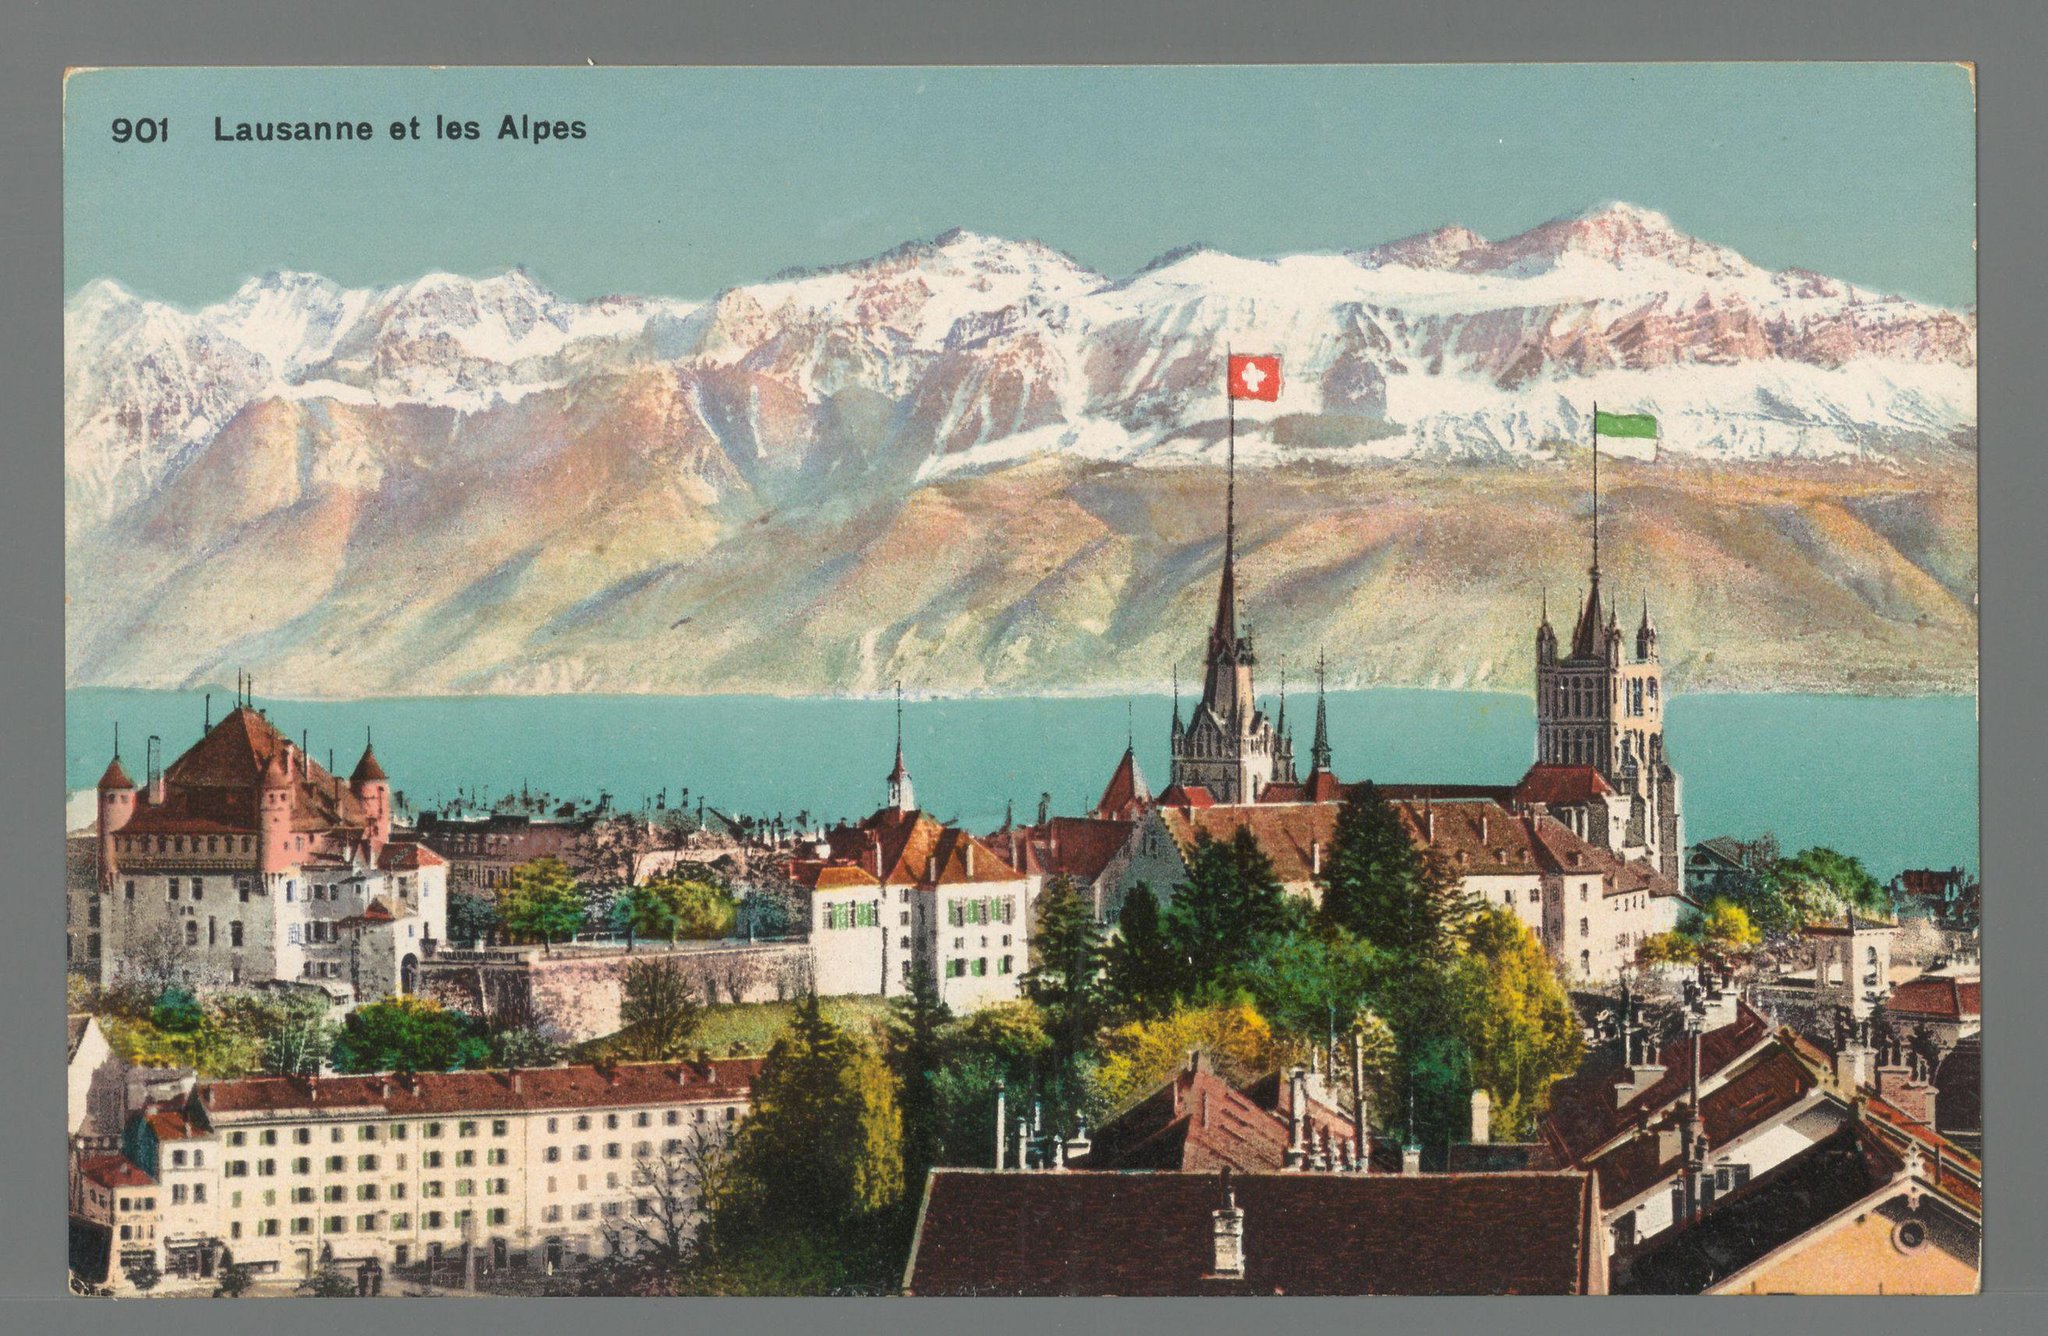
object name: ansichtkaart, prentbriefkaart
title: Lausanne et les Alpes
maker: Anonymous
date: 1905-1920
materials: cardboard, photographic process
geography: neuchatel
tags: lake, mountain-range, snow peaks, prospect of city, town panorama, silhouette of city